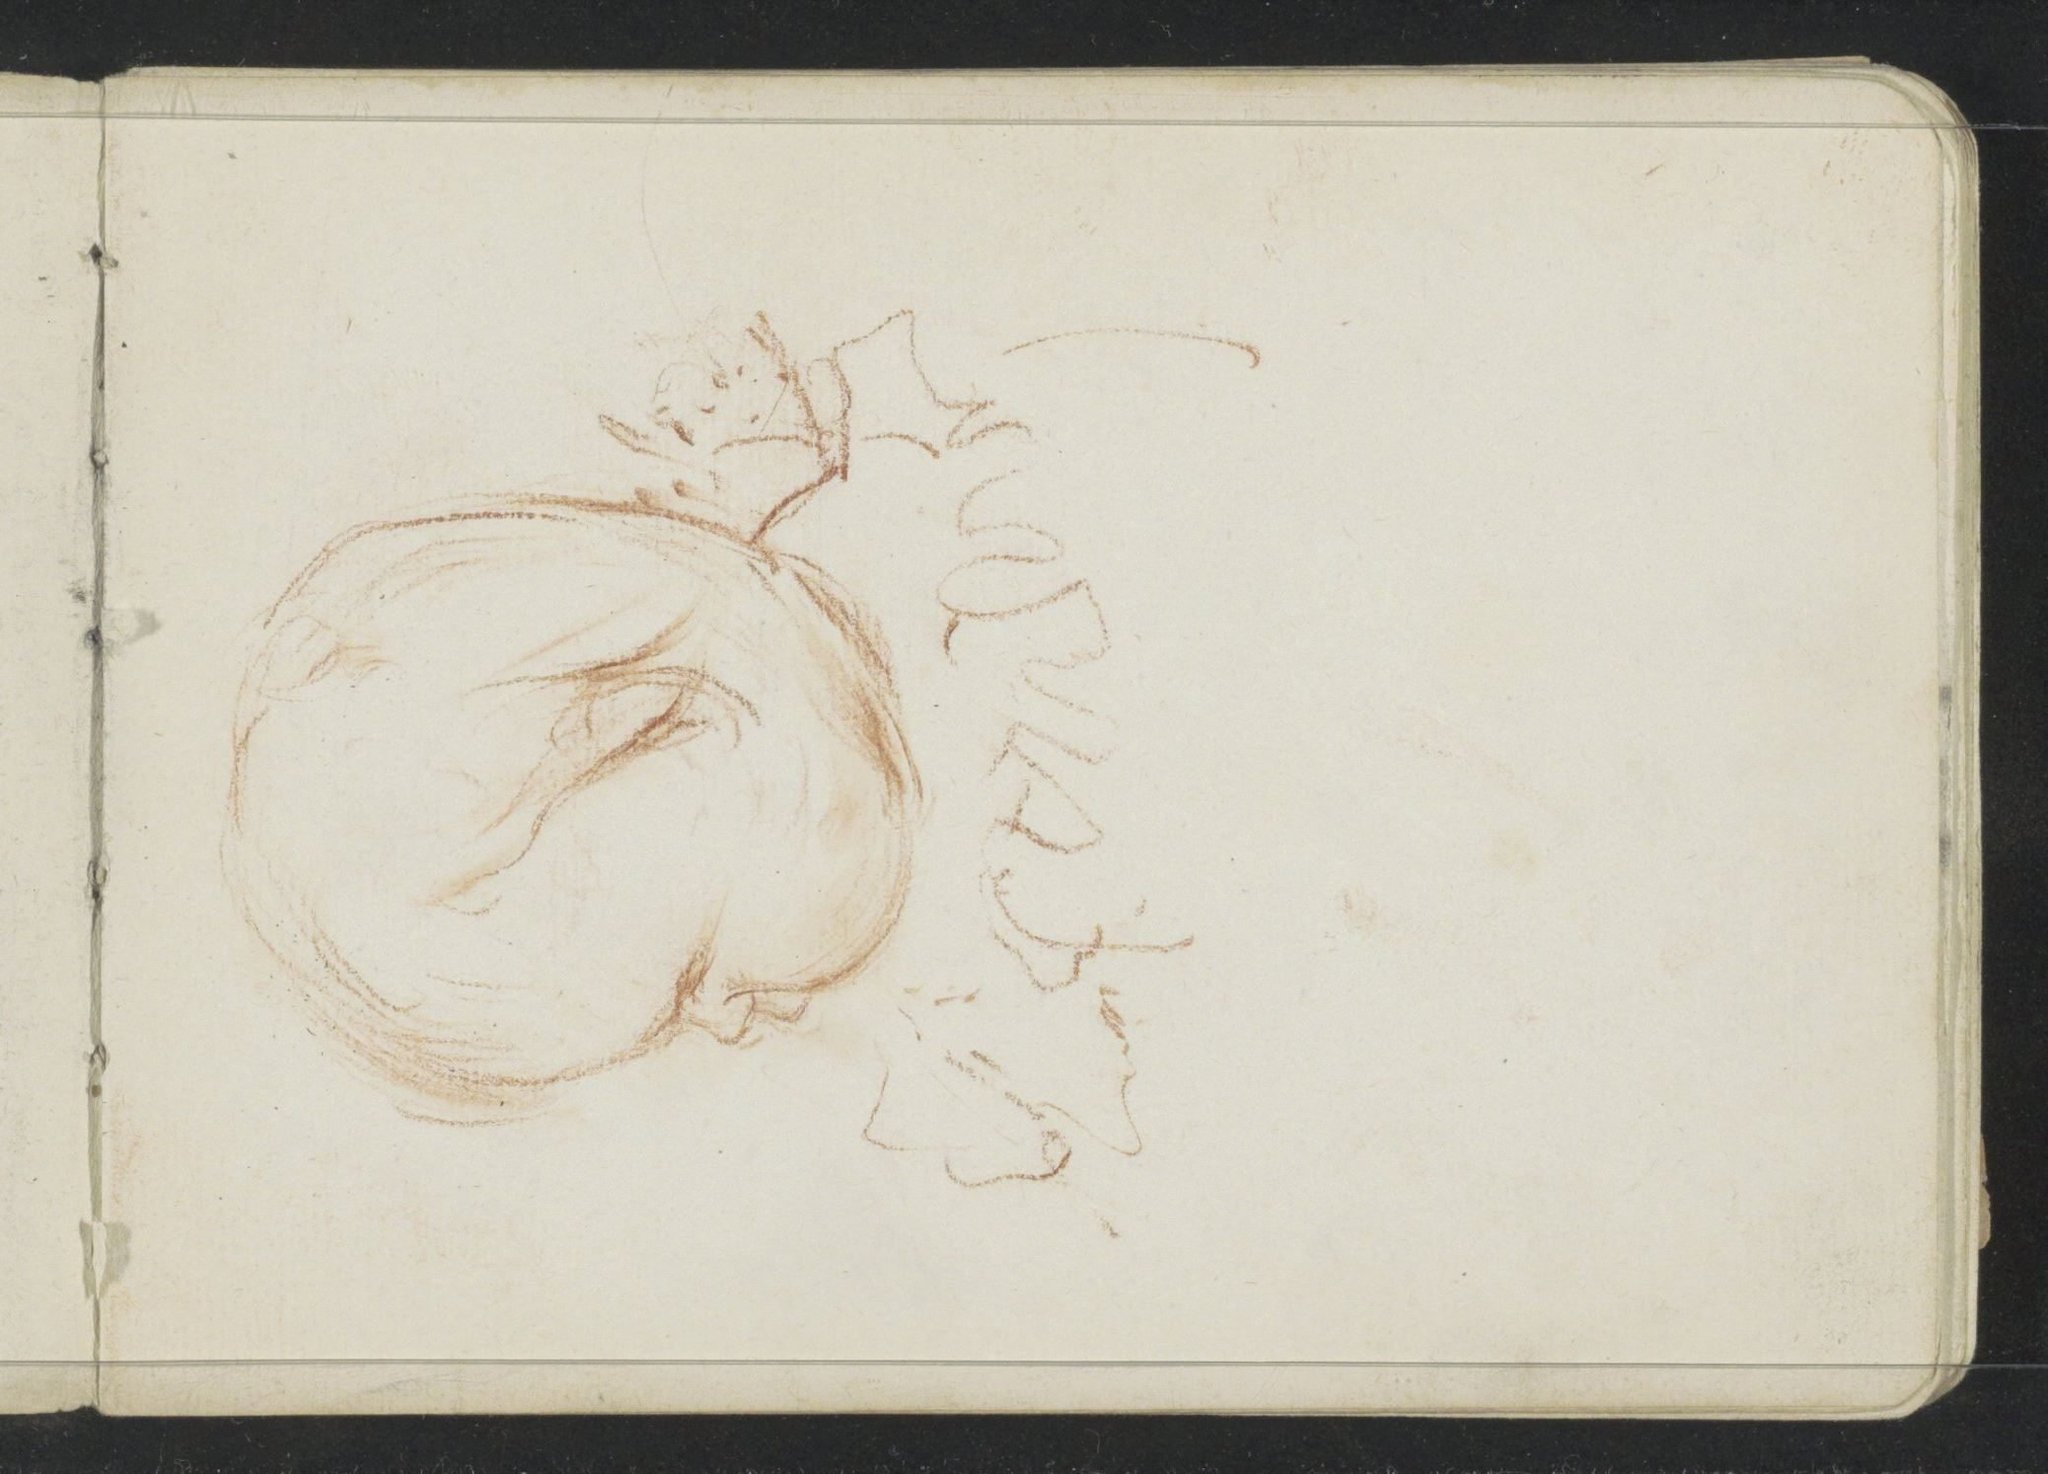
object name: sketchbook leaf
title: Kind in een blouse met kraag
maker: johanna van de kamer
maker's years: 1873-1922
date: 1883-1922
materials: chalk, paper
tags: child, neck-gear: collar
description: Blad 2 recto uit een schetsboek met 27 bladen.